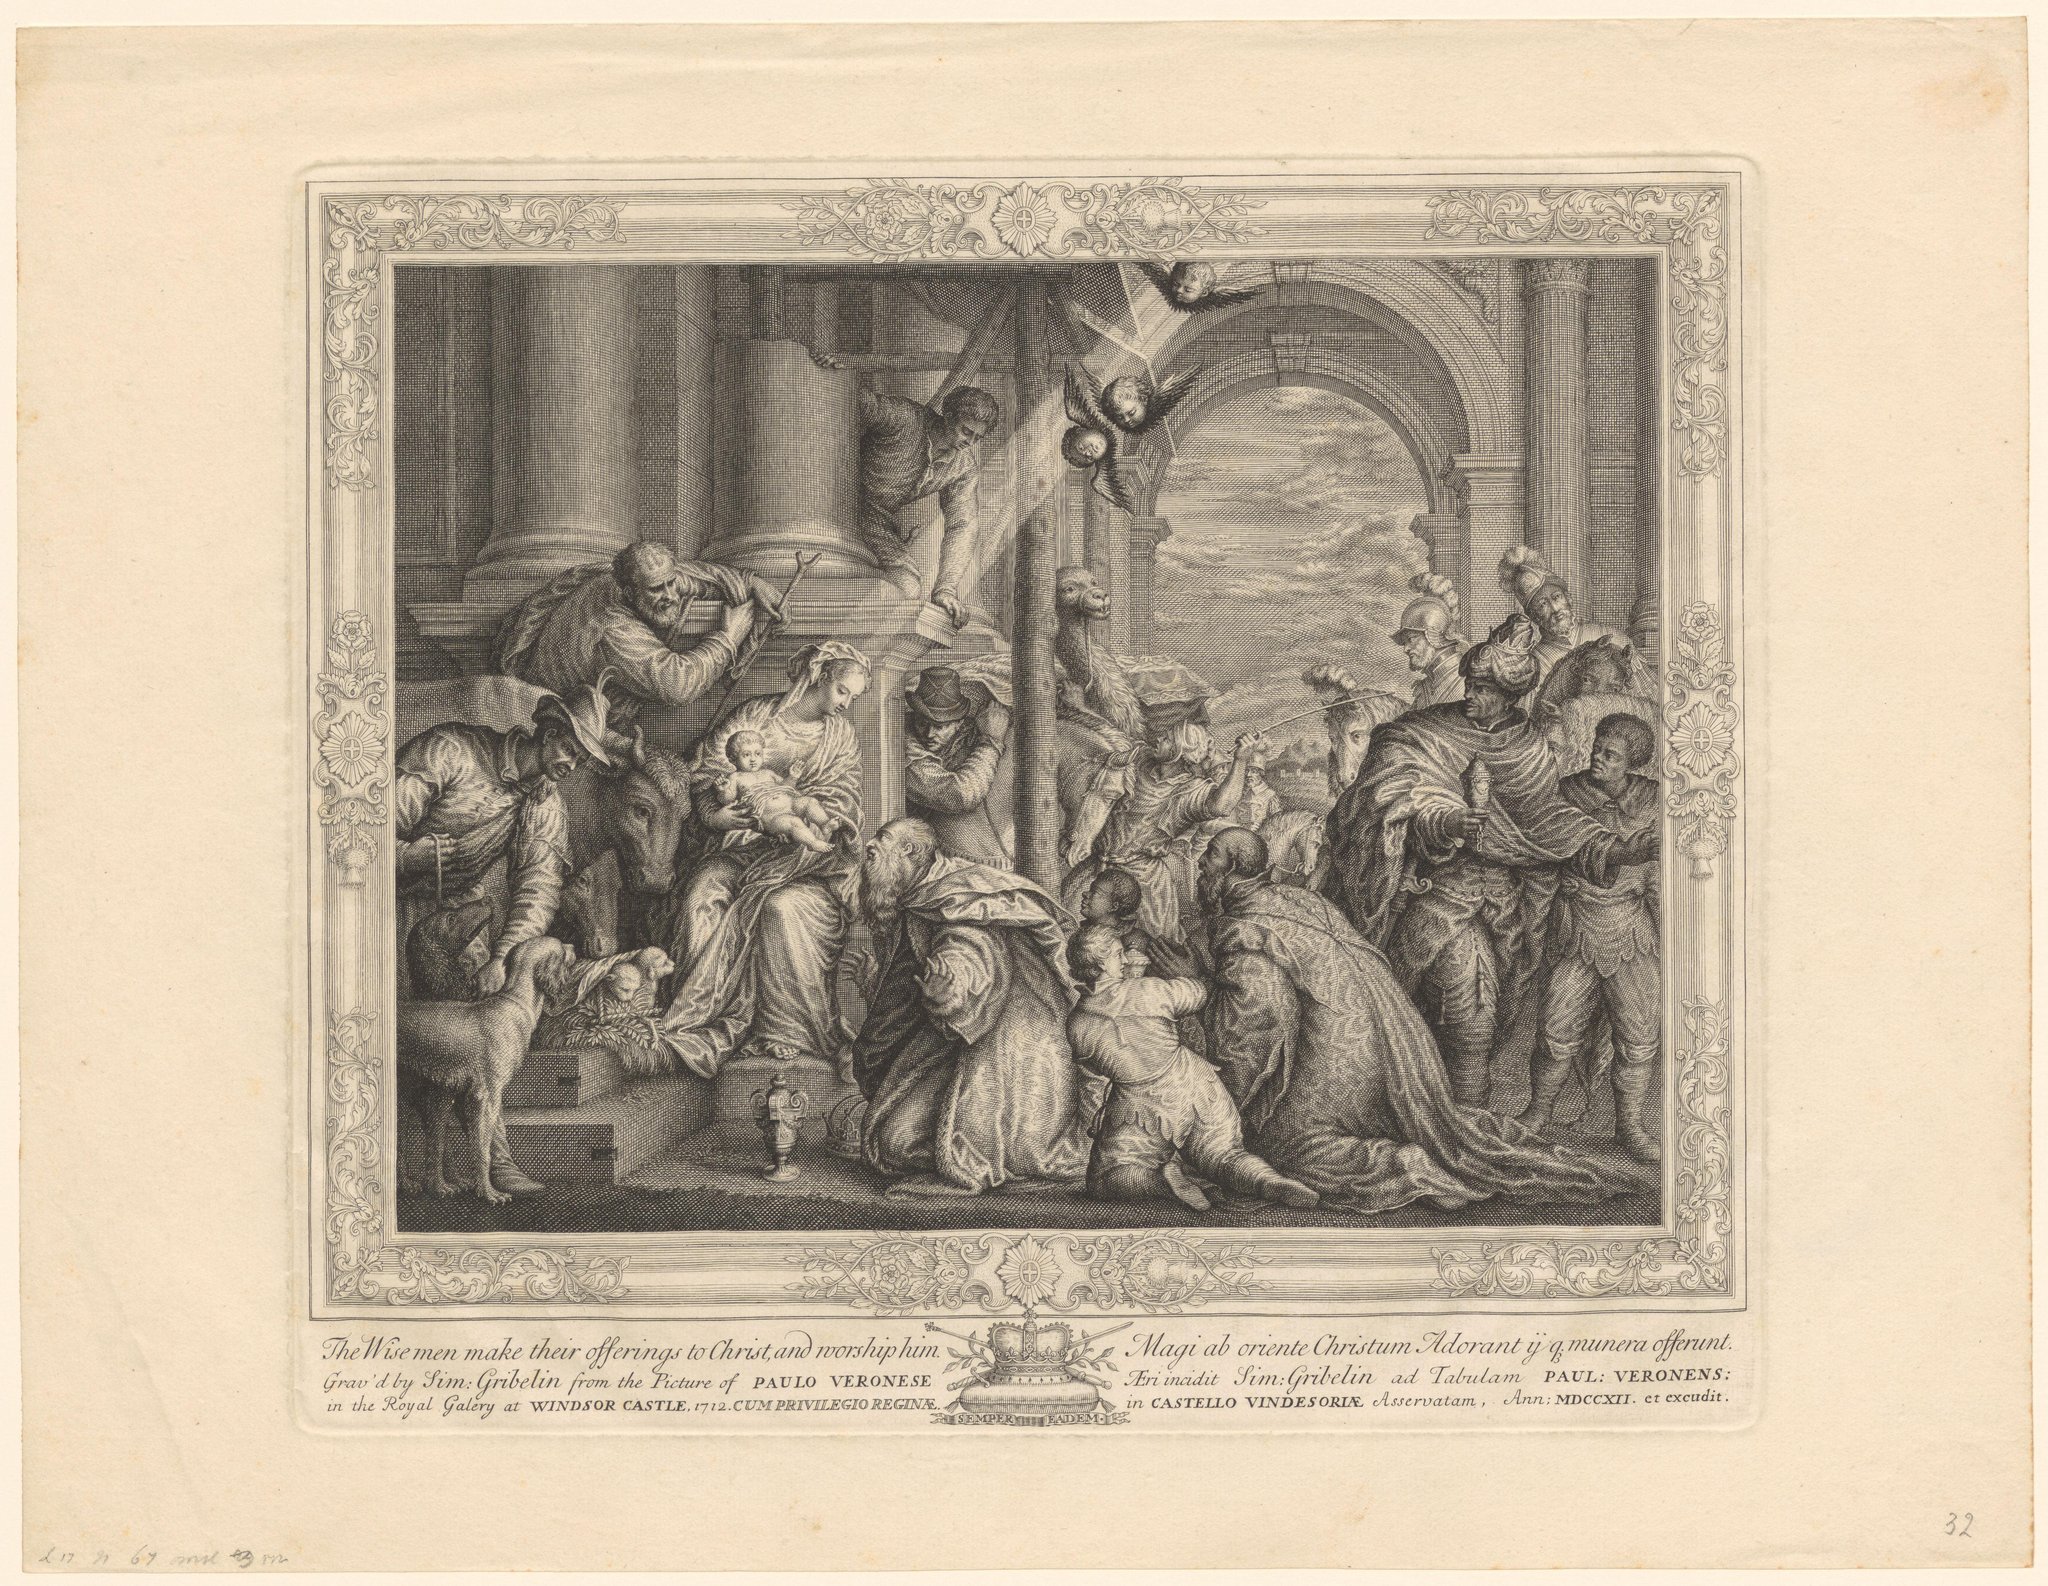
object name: print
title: Aanbidding der Koningen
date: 1712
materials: paper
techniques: engraving, etching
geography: london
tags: adoration of the kings: the wise men present their gifts to the christ-child (gold, frankincense and myrrh)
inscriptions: collector's mark: Lugt 240